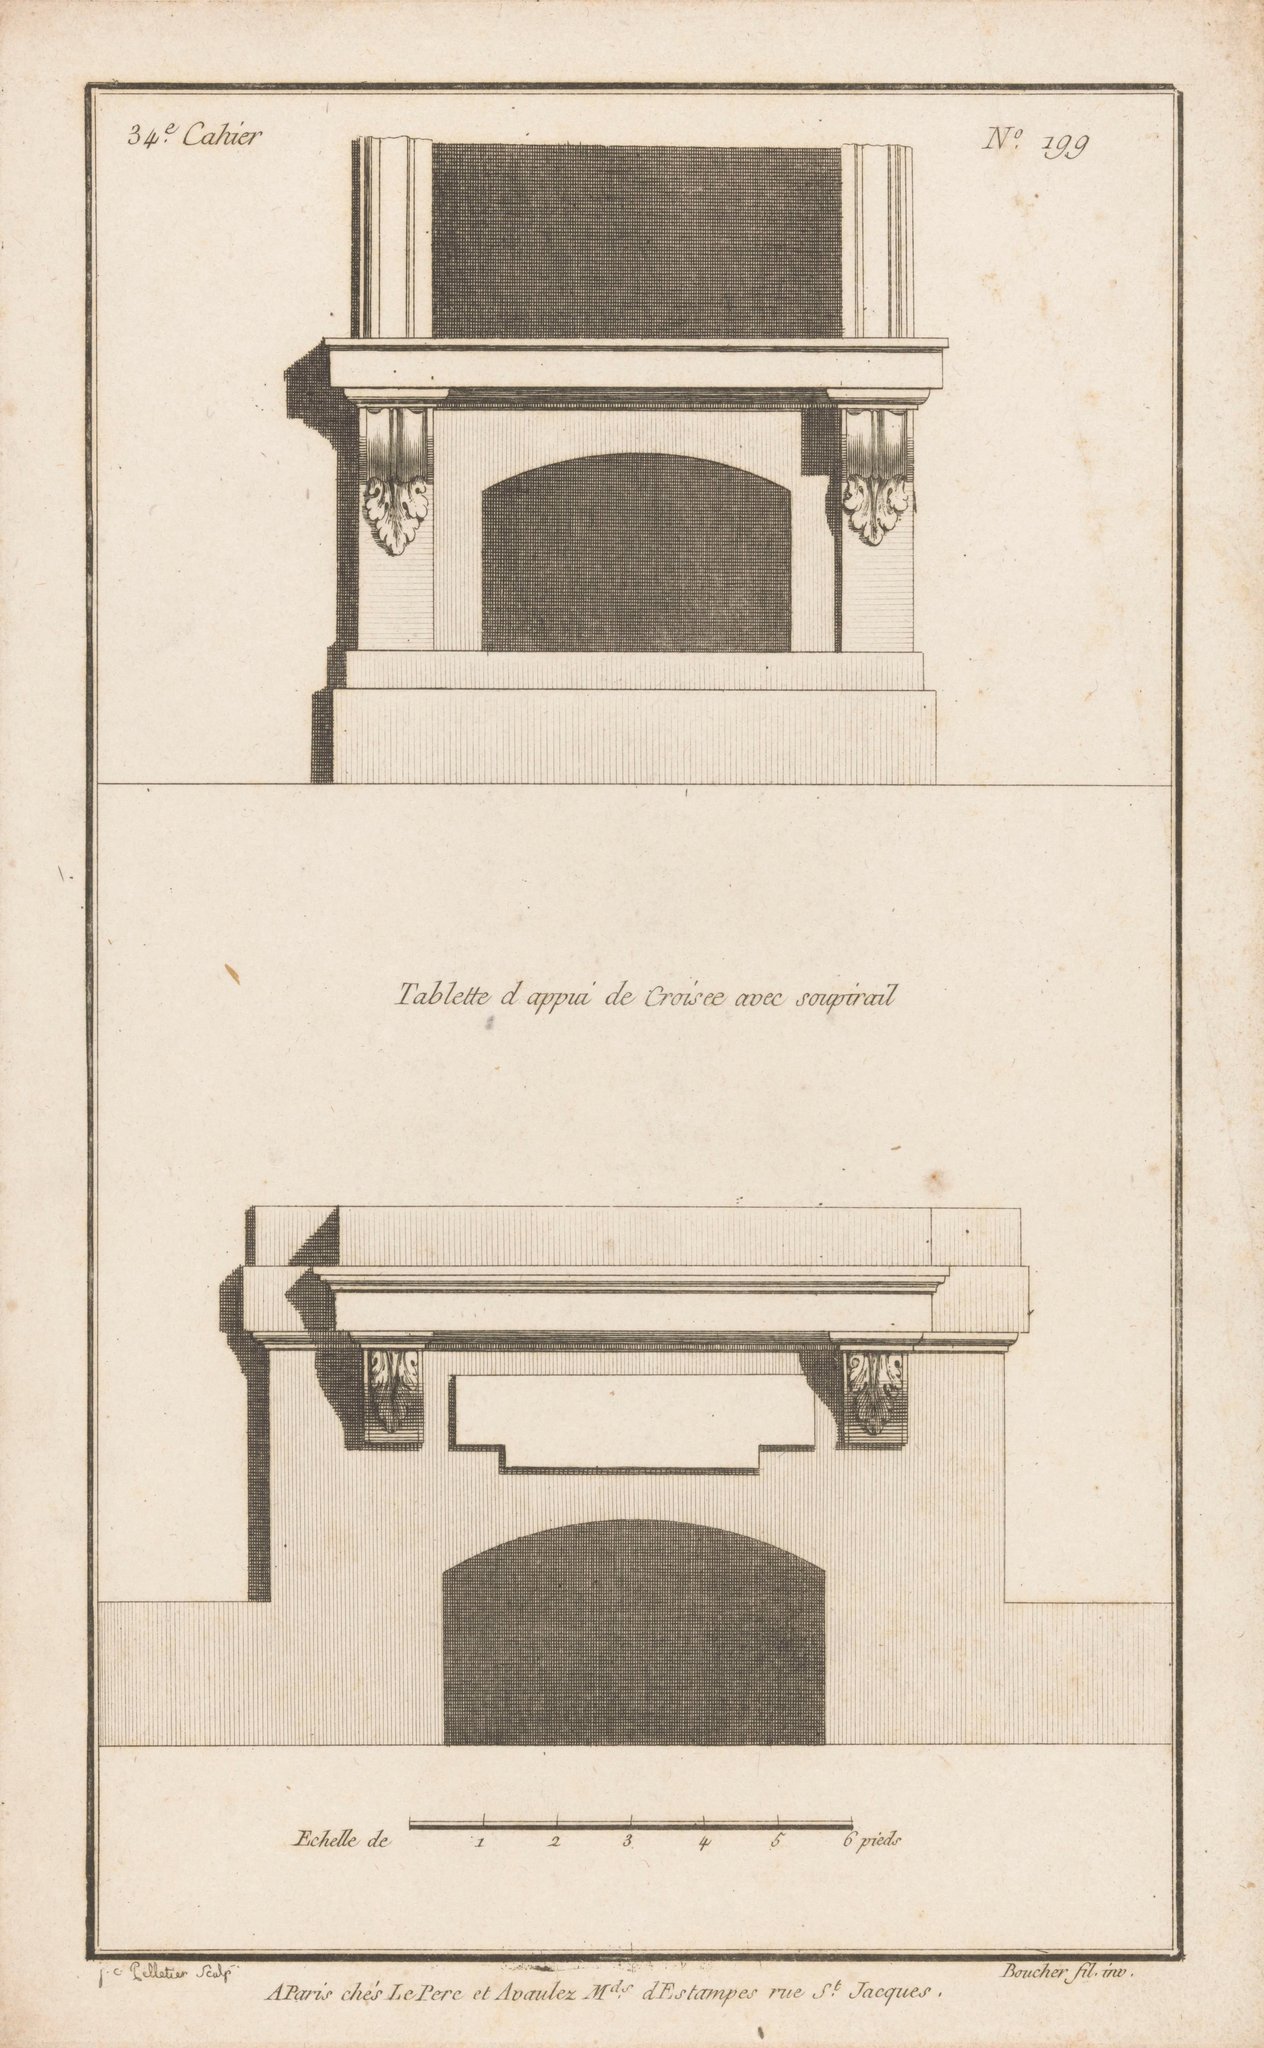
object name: print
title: Vensterbanken en balkons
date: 1772-1779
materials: paper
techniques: engraving, etching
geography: paris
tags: window, basement, cellar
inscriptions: collector's mark: Lugt 2760, collector's mark: Lugt 2228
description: Twee geornamenteerde vensterbanken met daaronder keldergaten. Bij de bovenste vensterbank is een deur- of raamopening weergegeven. Prentnummer 199.